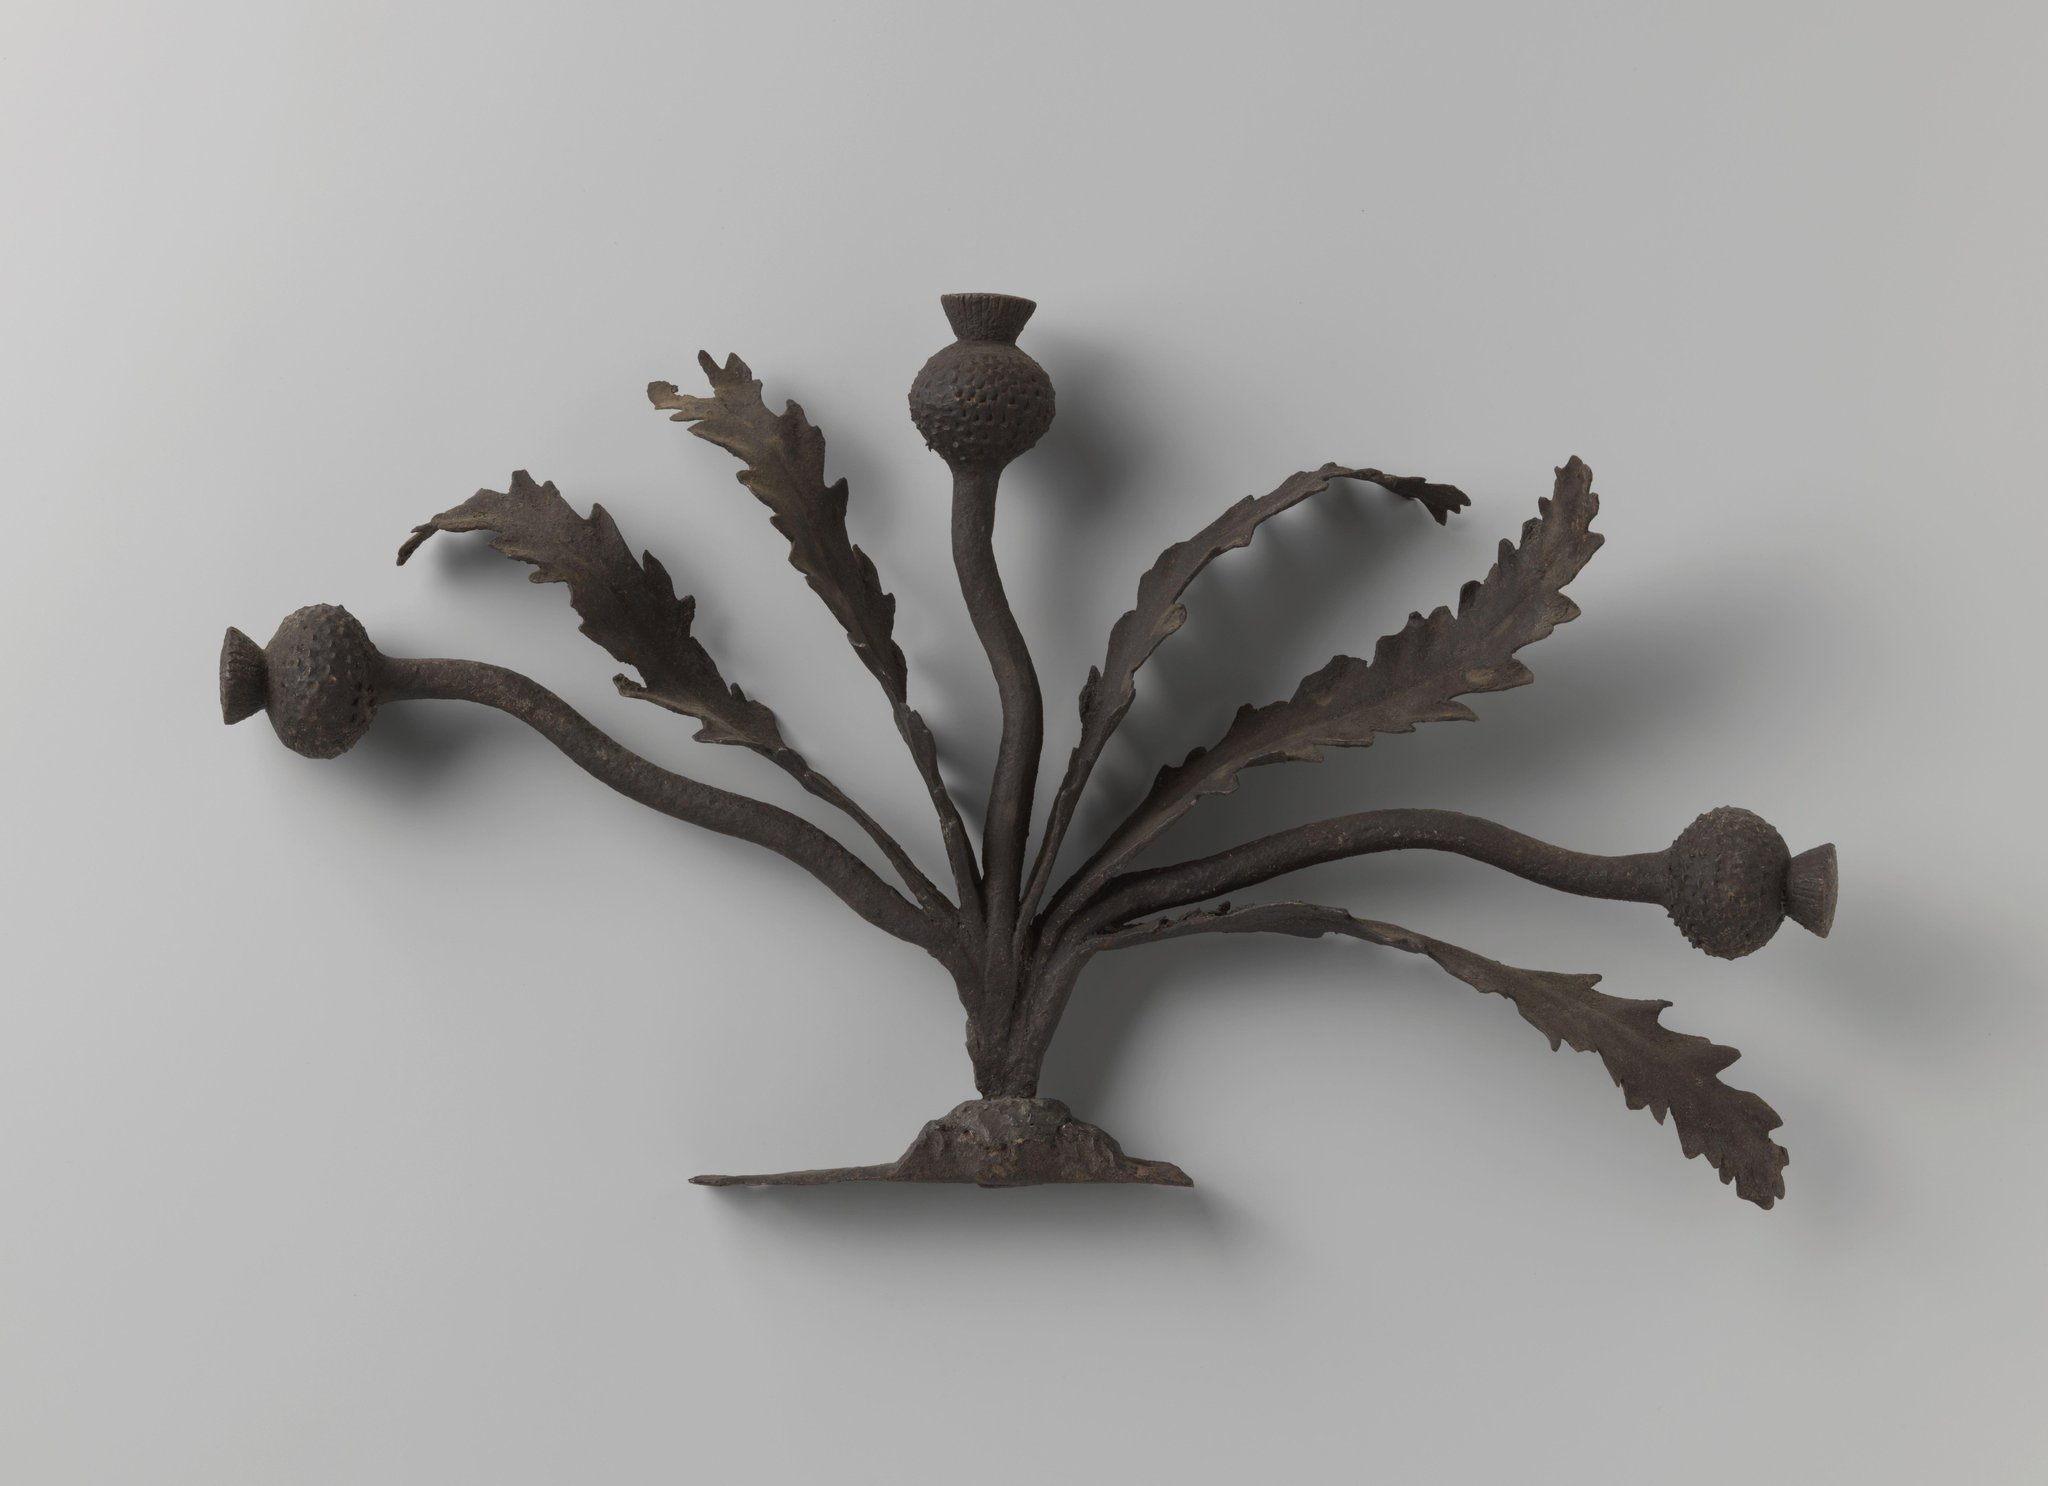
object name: decoratief object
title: Distel met drie bloemen en vijf bladeren.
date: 1400-1950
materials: iron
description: Een ijzeren bloem, distel met drie bloemen en vijf bladeren.